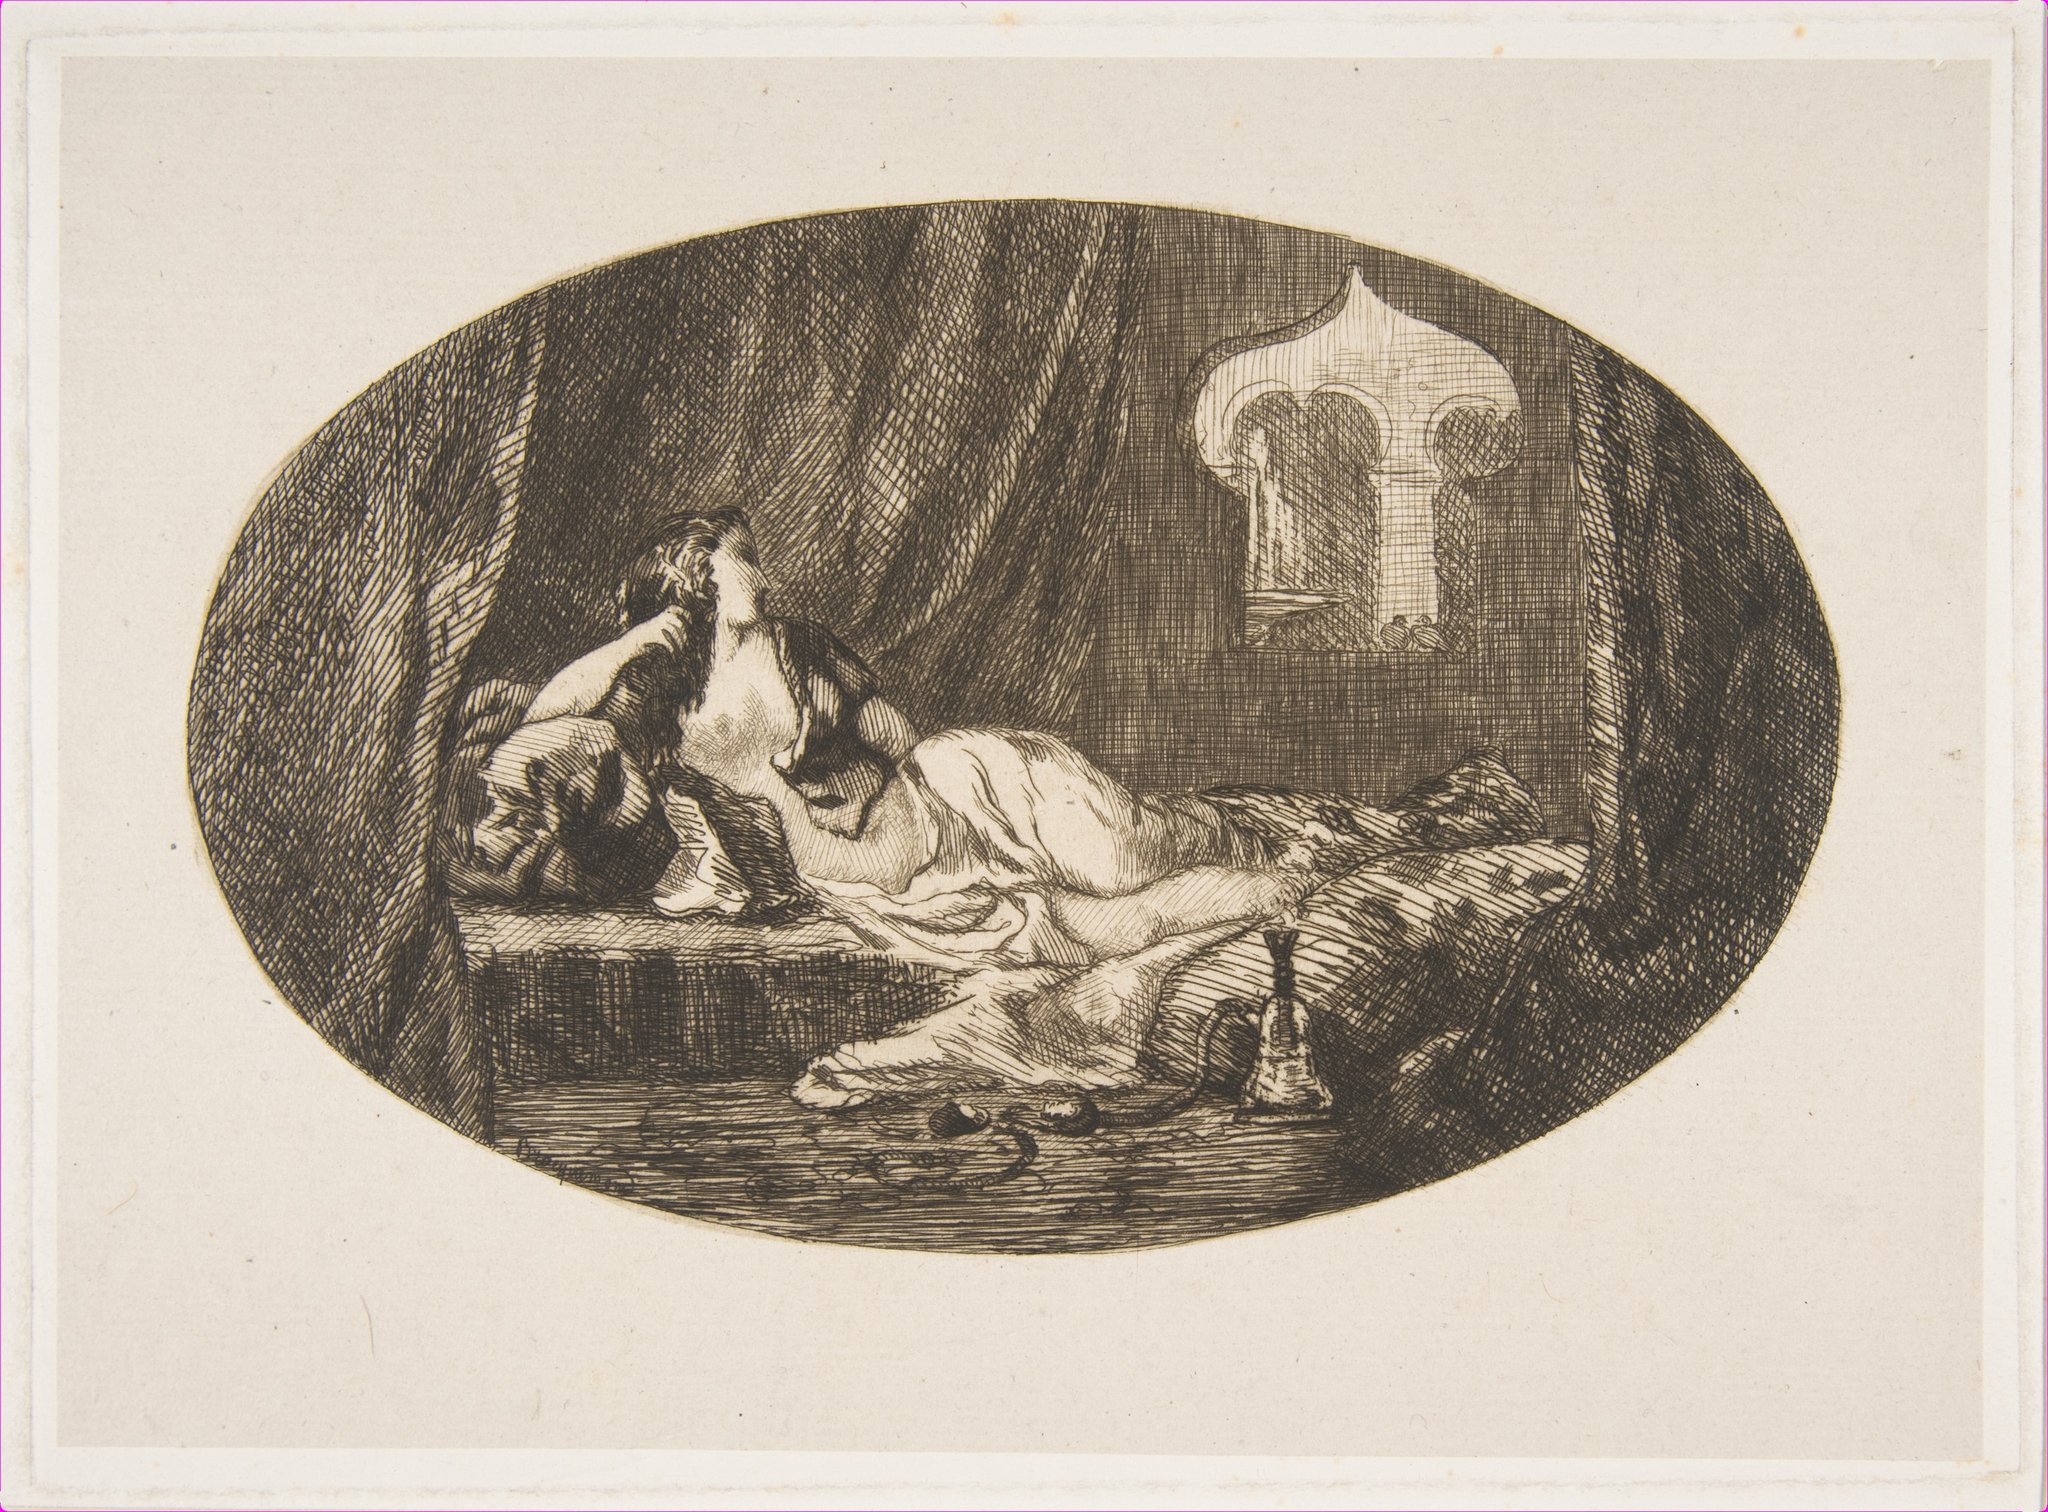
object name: print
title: Odalisque reclining in a harem, from "Titres de Romance"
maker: félix bracquemond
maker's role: artist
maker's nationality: french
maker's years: 1833-1914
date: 1857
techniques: printmaking, etching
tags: female nudes